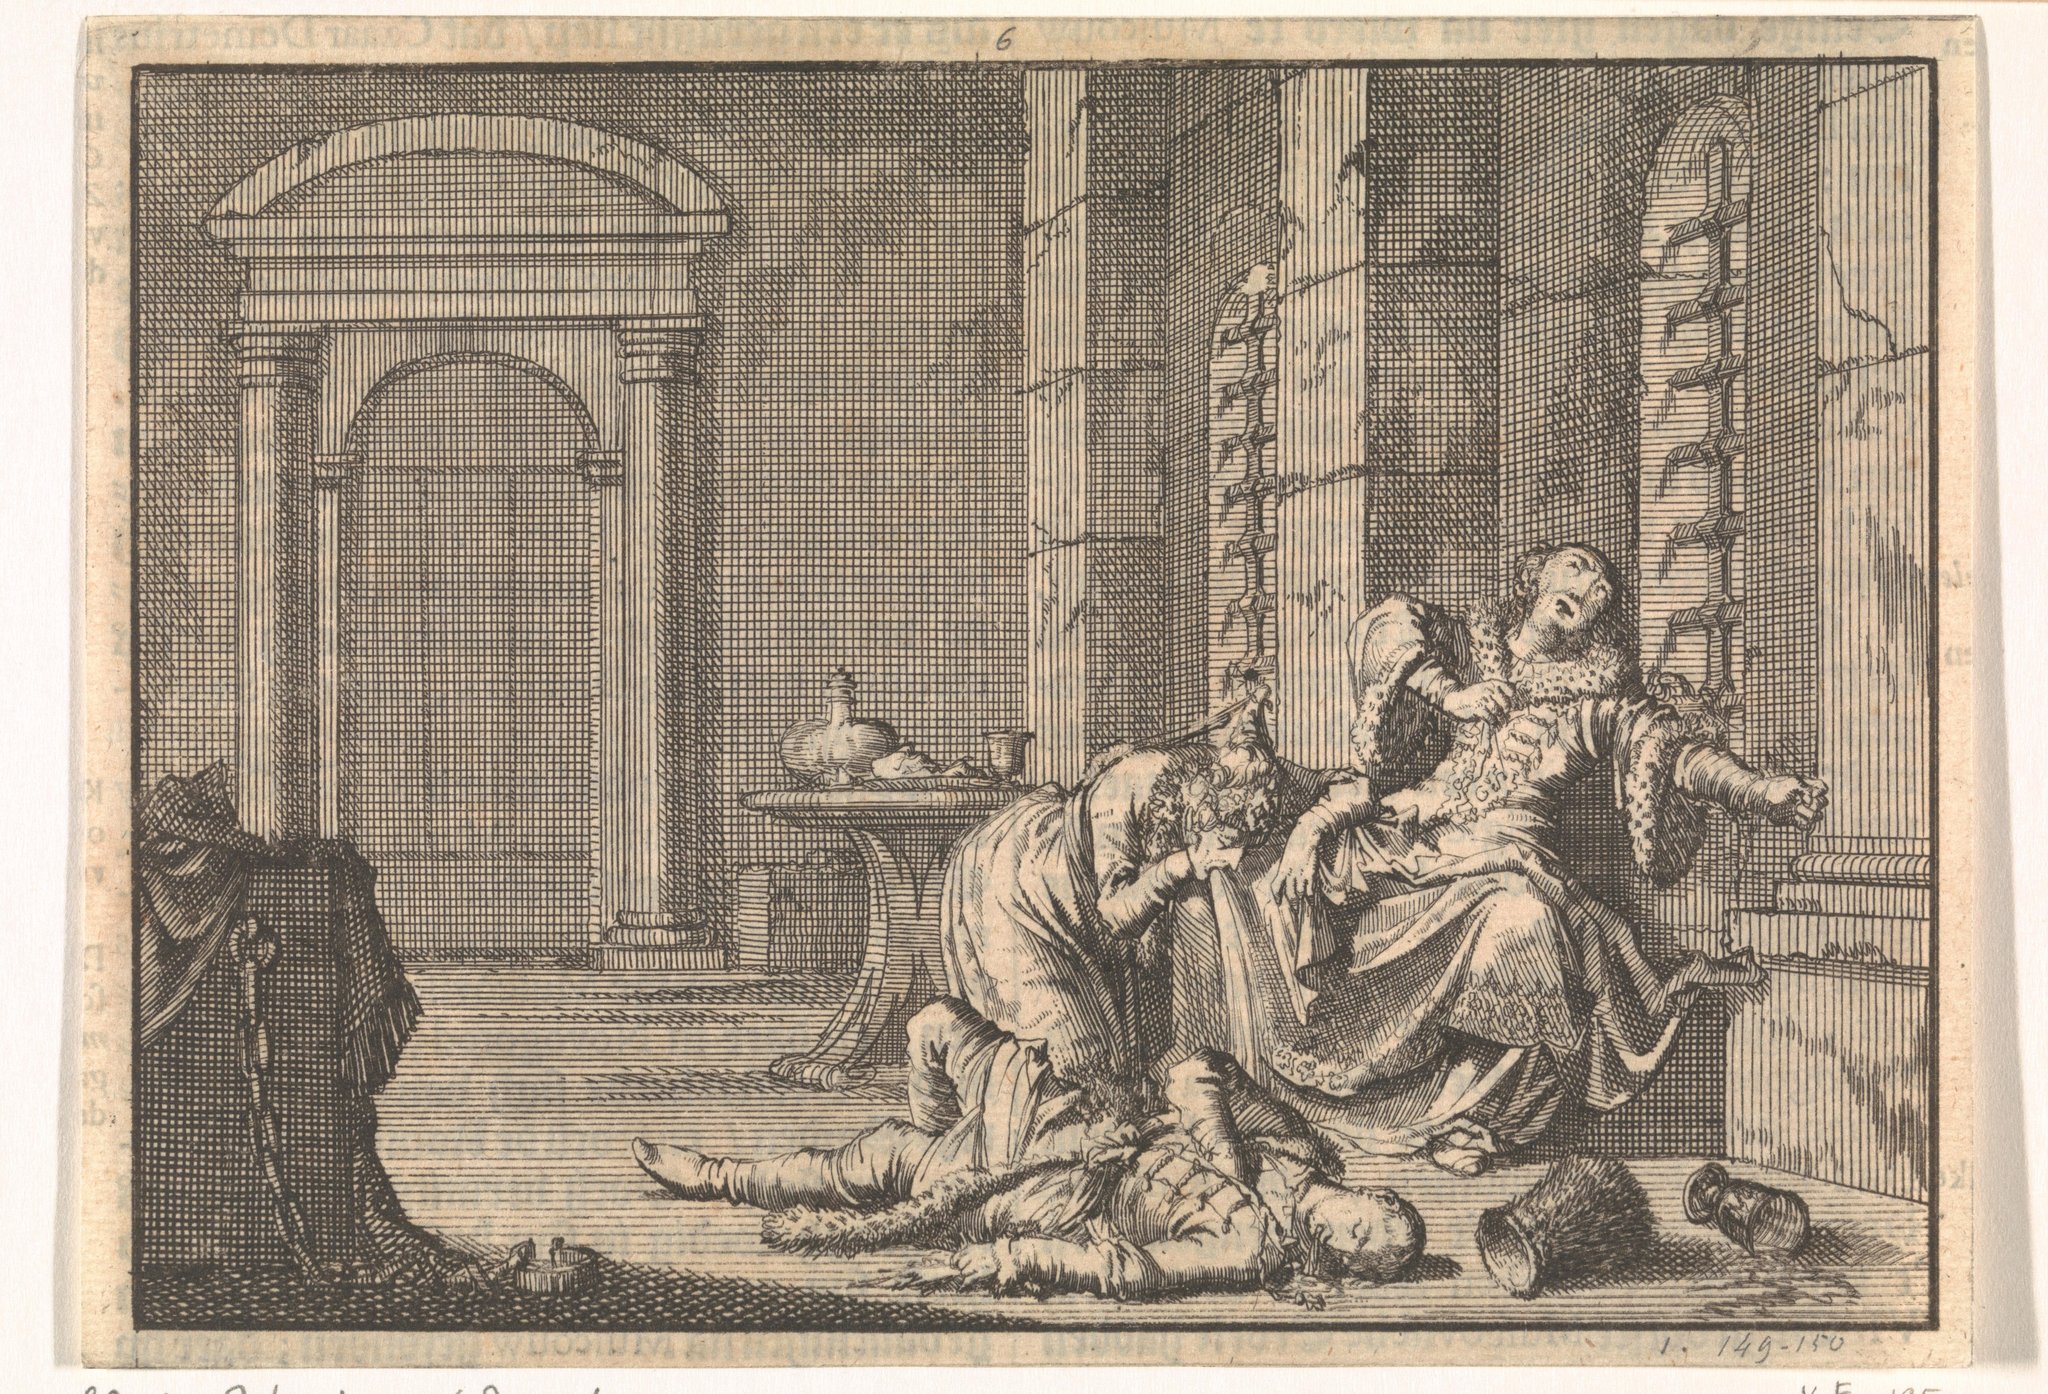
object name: book illustration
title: Tsaar Fedor Borissowitz sterft vergiftigd in de gevangenis, 1605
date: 1698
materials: paper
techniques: etching, letterpress printing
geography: amsterdam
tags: prison, jail, violent death by poison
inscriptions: collector's mark: Lugt 2228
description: Illustratie uit: Gottfried, Johann Ludwig. Historische kronyck; vervattende een (...) beschrijvingh der aldergedenckwaerdigste geschiedenissen des weerelds, van den aenvangh der scheppingh tot (...) 1576 (2 delen). Leiden: Pieter van der Aa, 1698, dl. I, p. 149.